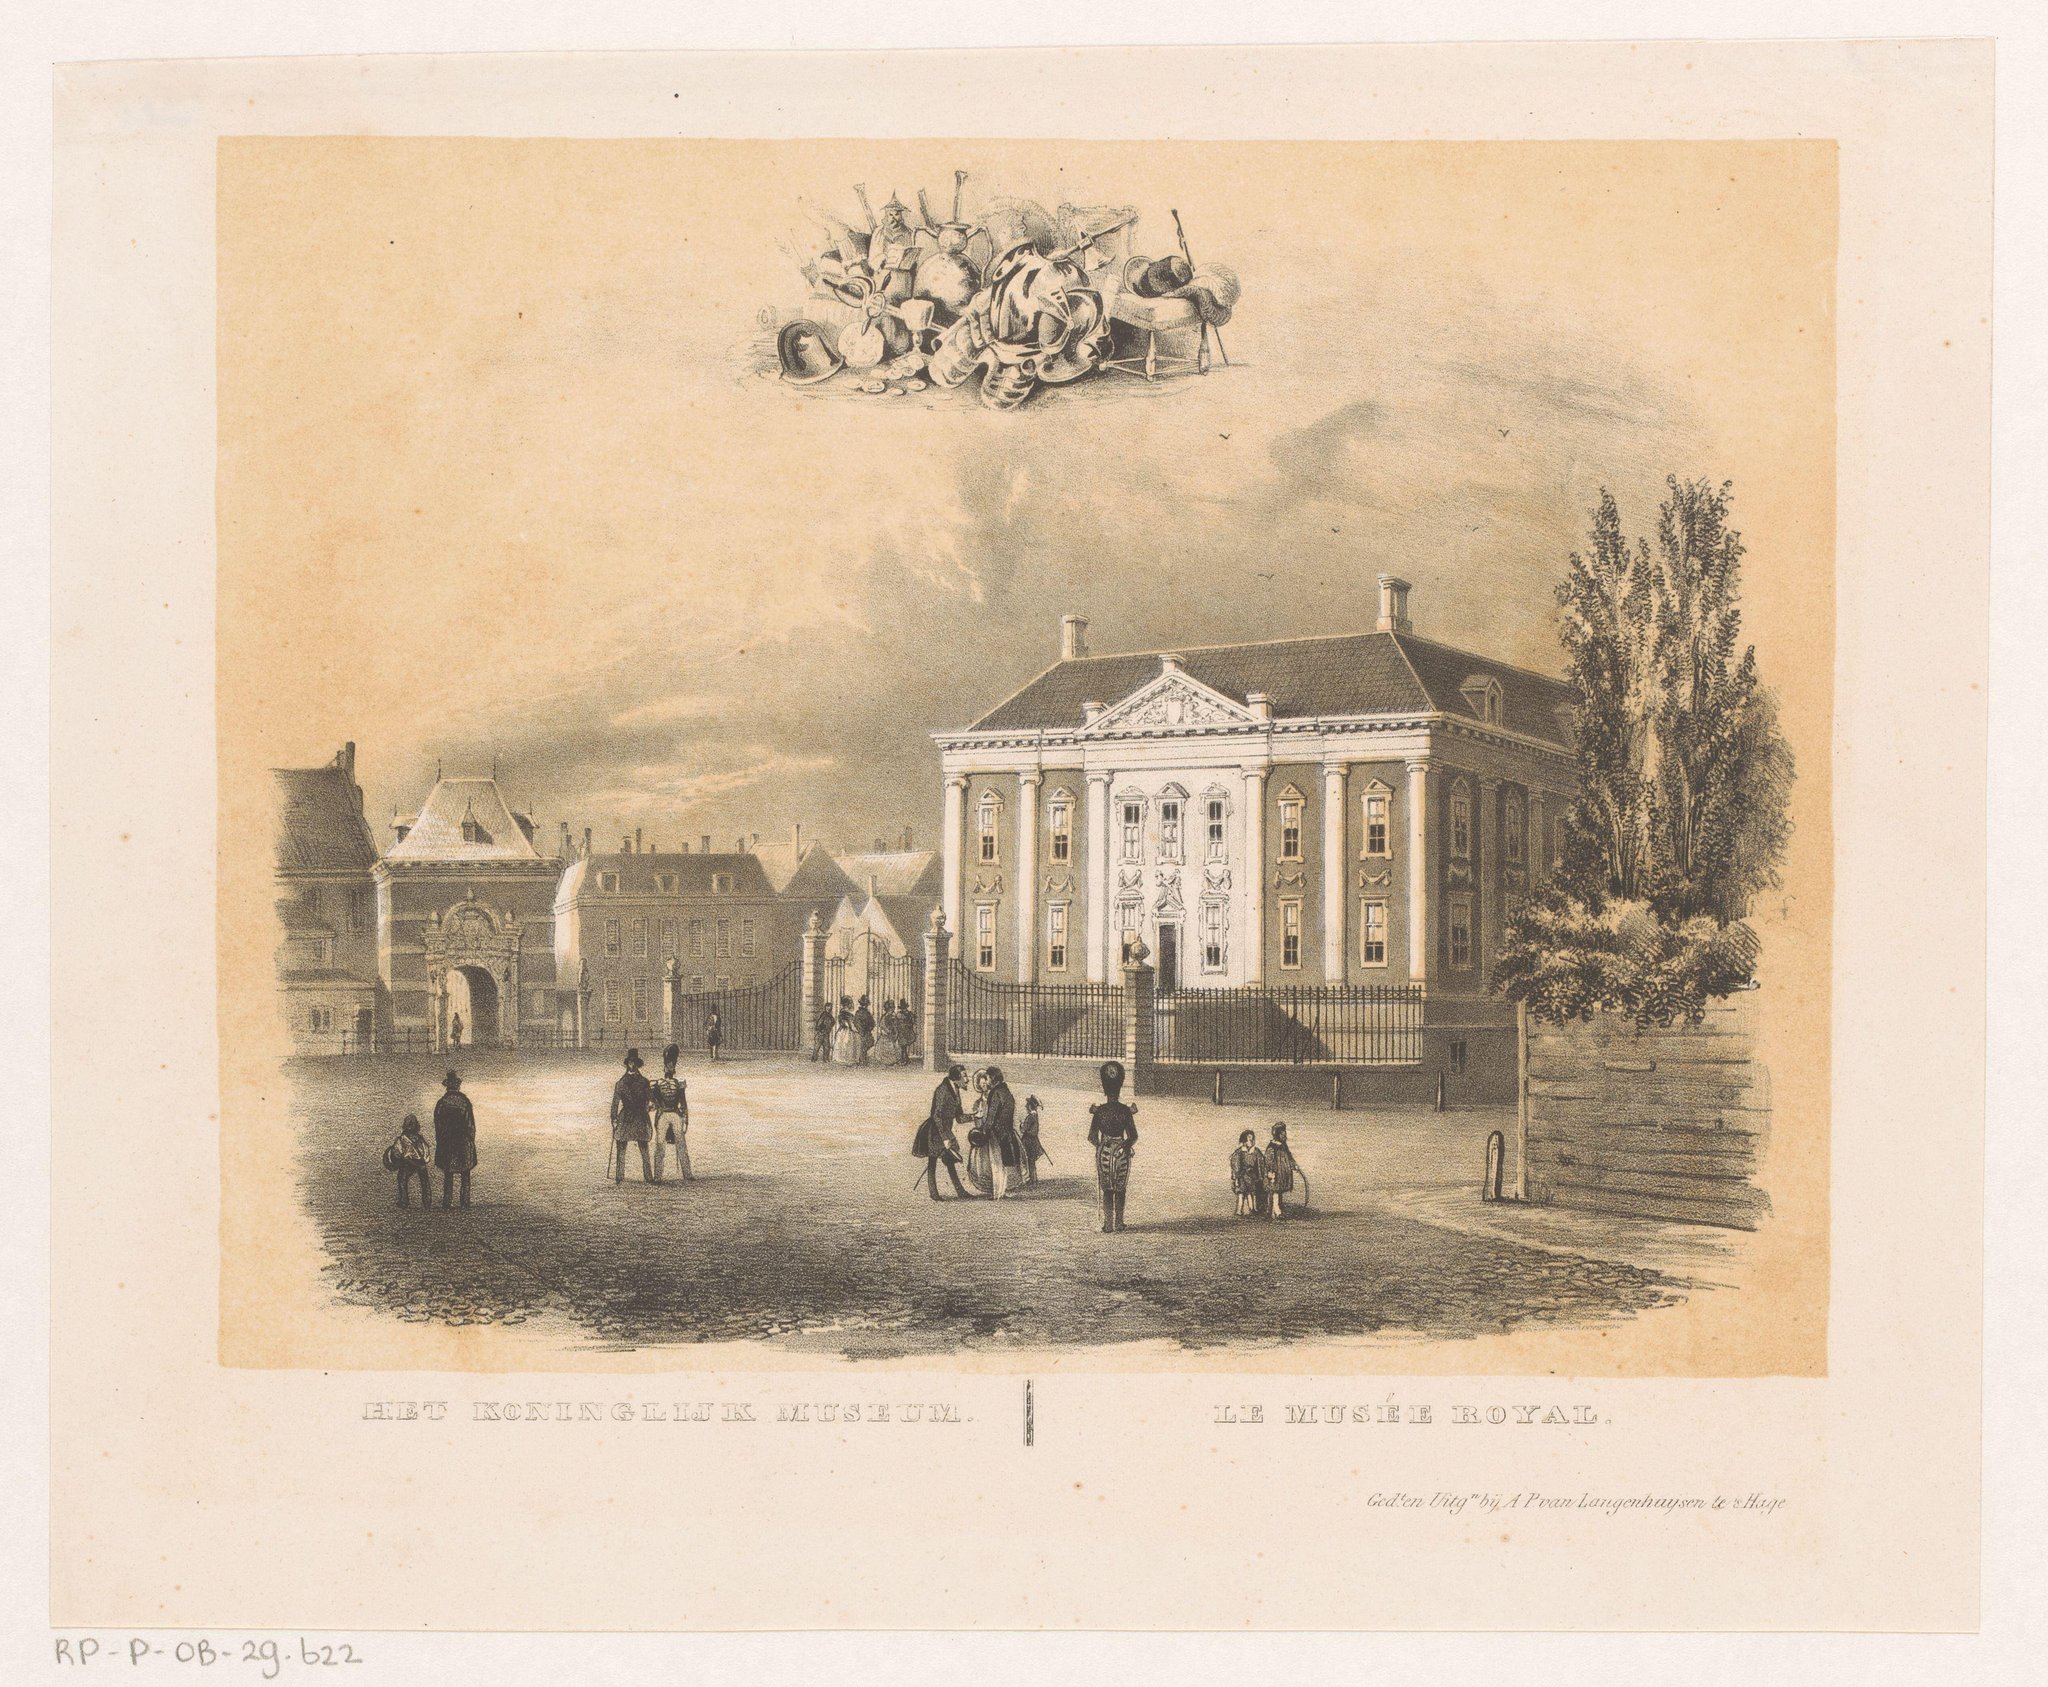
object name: print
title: Mauritshuis te Den Haag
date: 1830-1846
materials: paper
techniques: tone lithography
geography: the hague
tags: permanent exhibition, museum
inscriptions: collector's mark: Lugt 2228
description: Mensen op het plein voor het Mauritshuis. Links de Mauritspoort richting het Binnenhof.